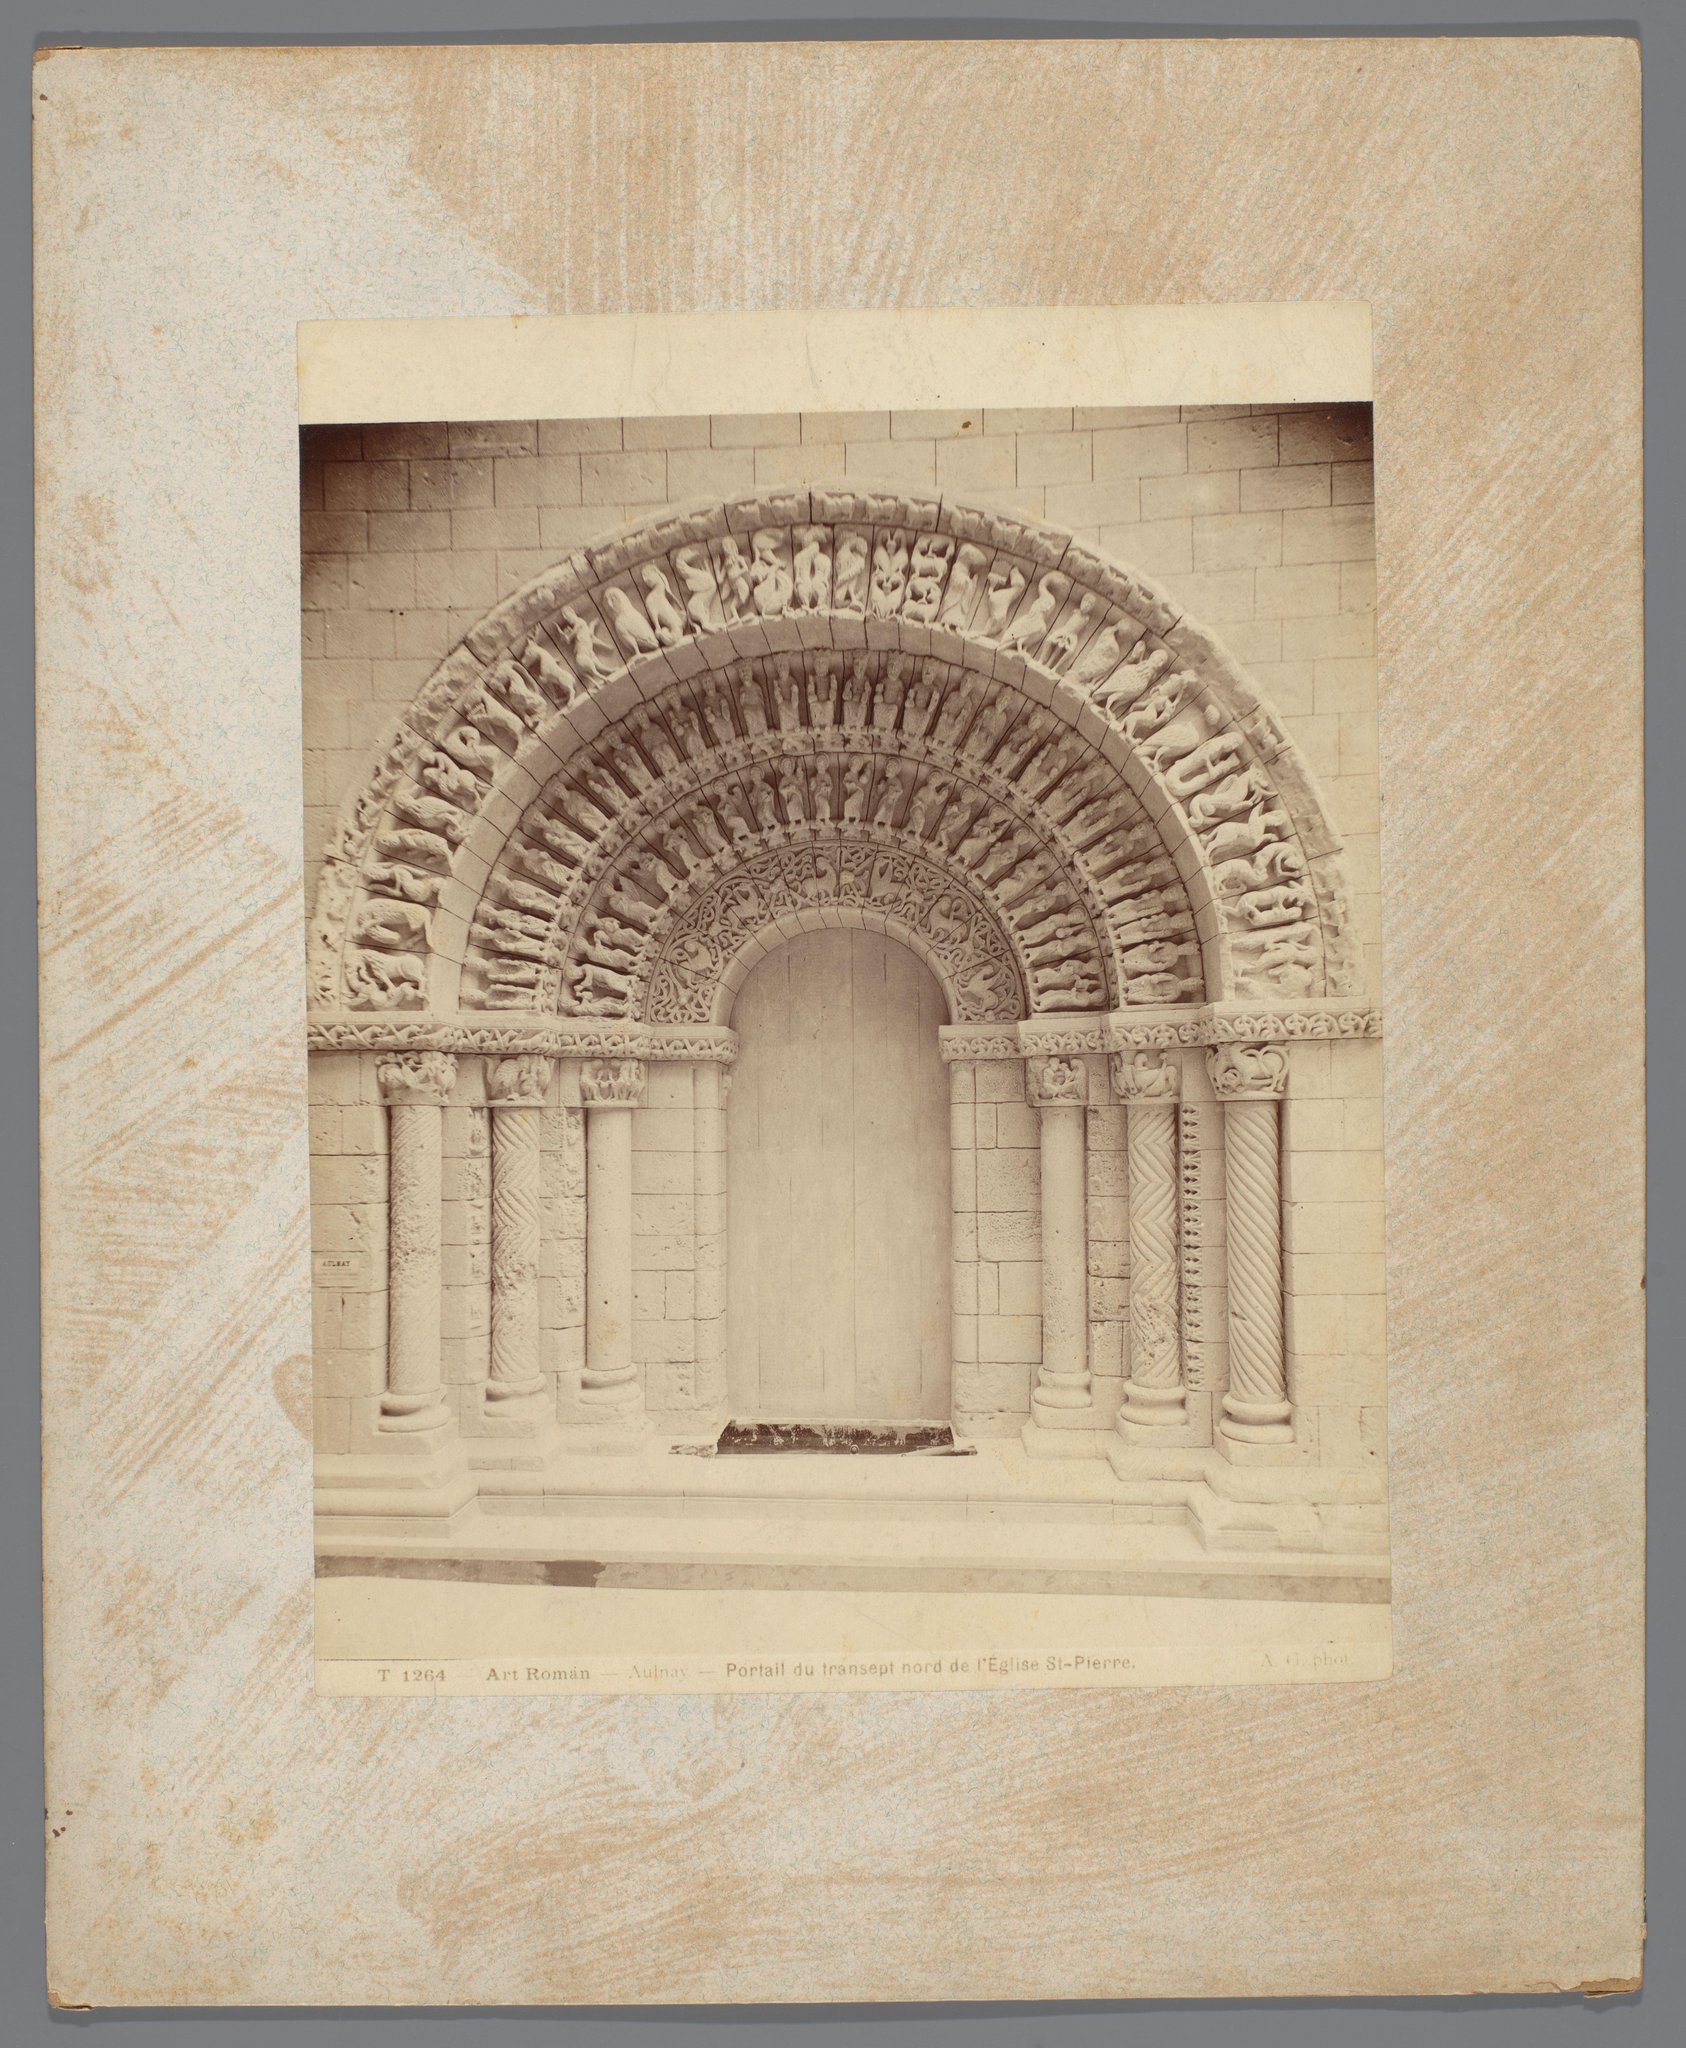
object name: photograph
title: Portail du transept nord de l'Église St-Pierre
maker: adolphe giraudon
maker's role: publisher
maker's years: 1849-1929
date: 1850-1900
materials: cardboard, photographic support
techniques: albumen print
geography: aulnay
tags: church (exterior), gate, entrance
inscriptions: number: ‘T 1264’, inscription: ‘Aulnay’, inscription: ‘A.G. phot.’